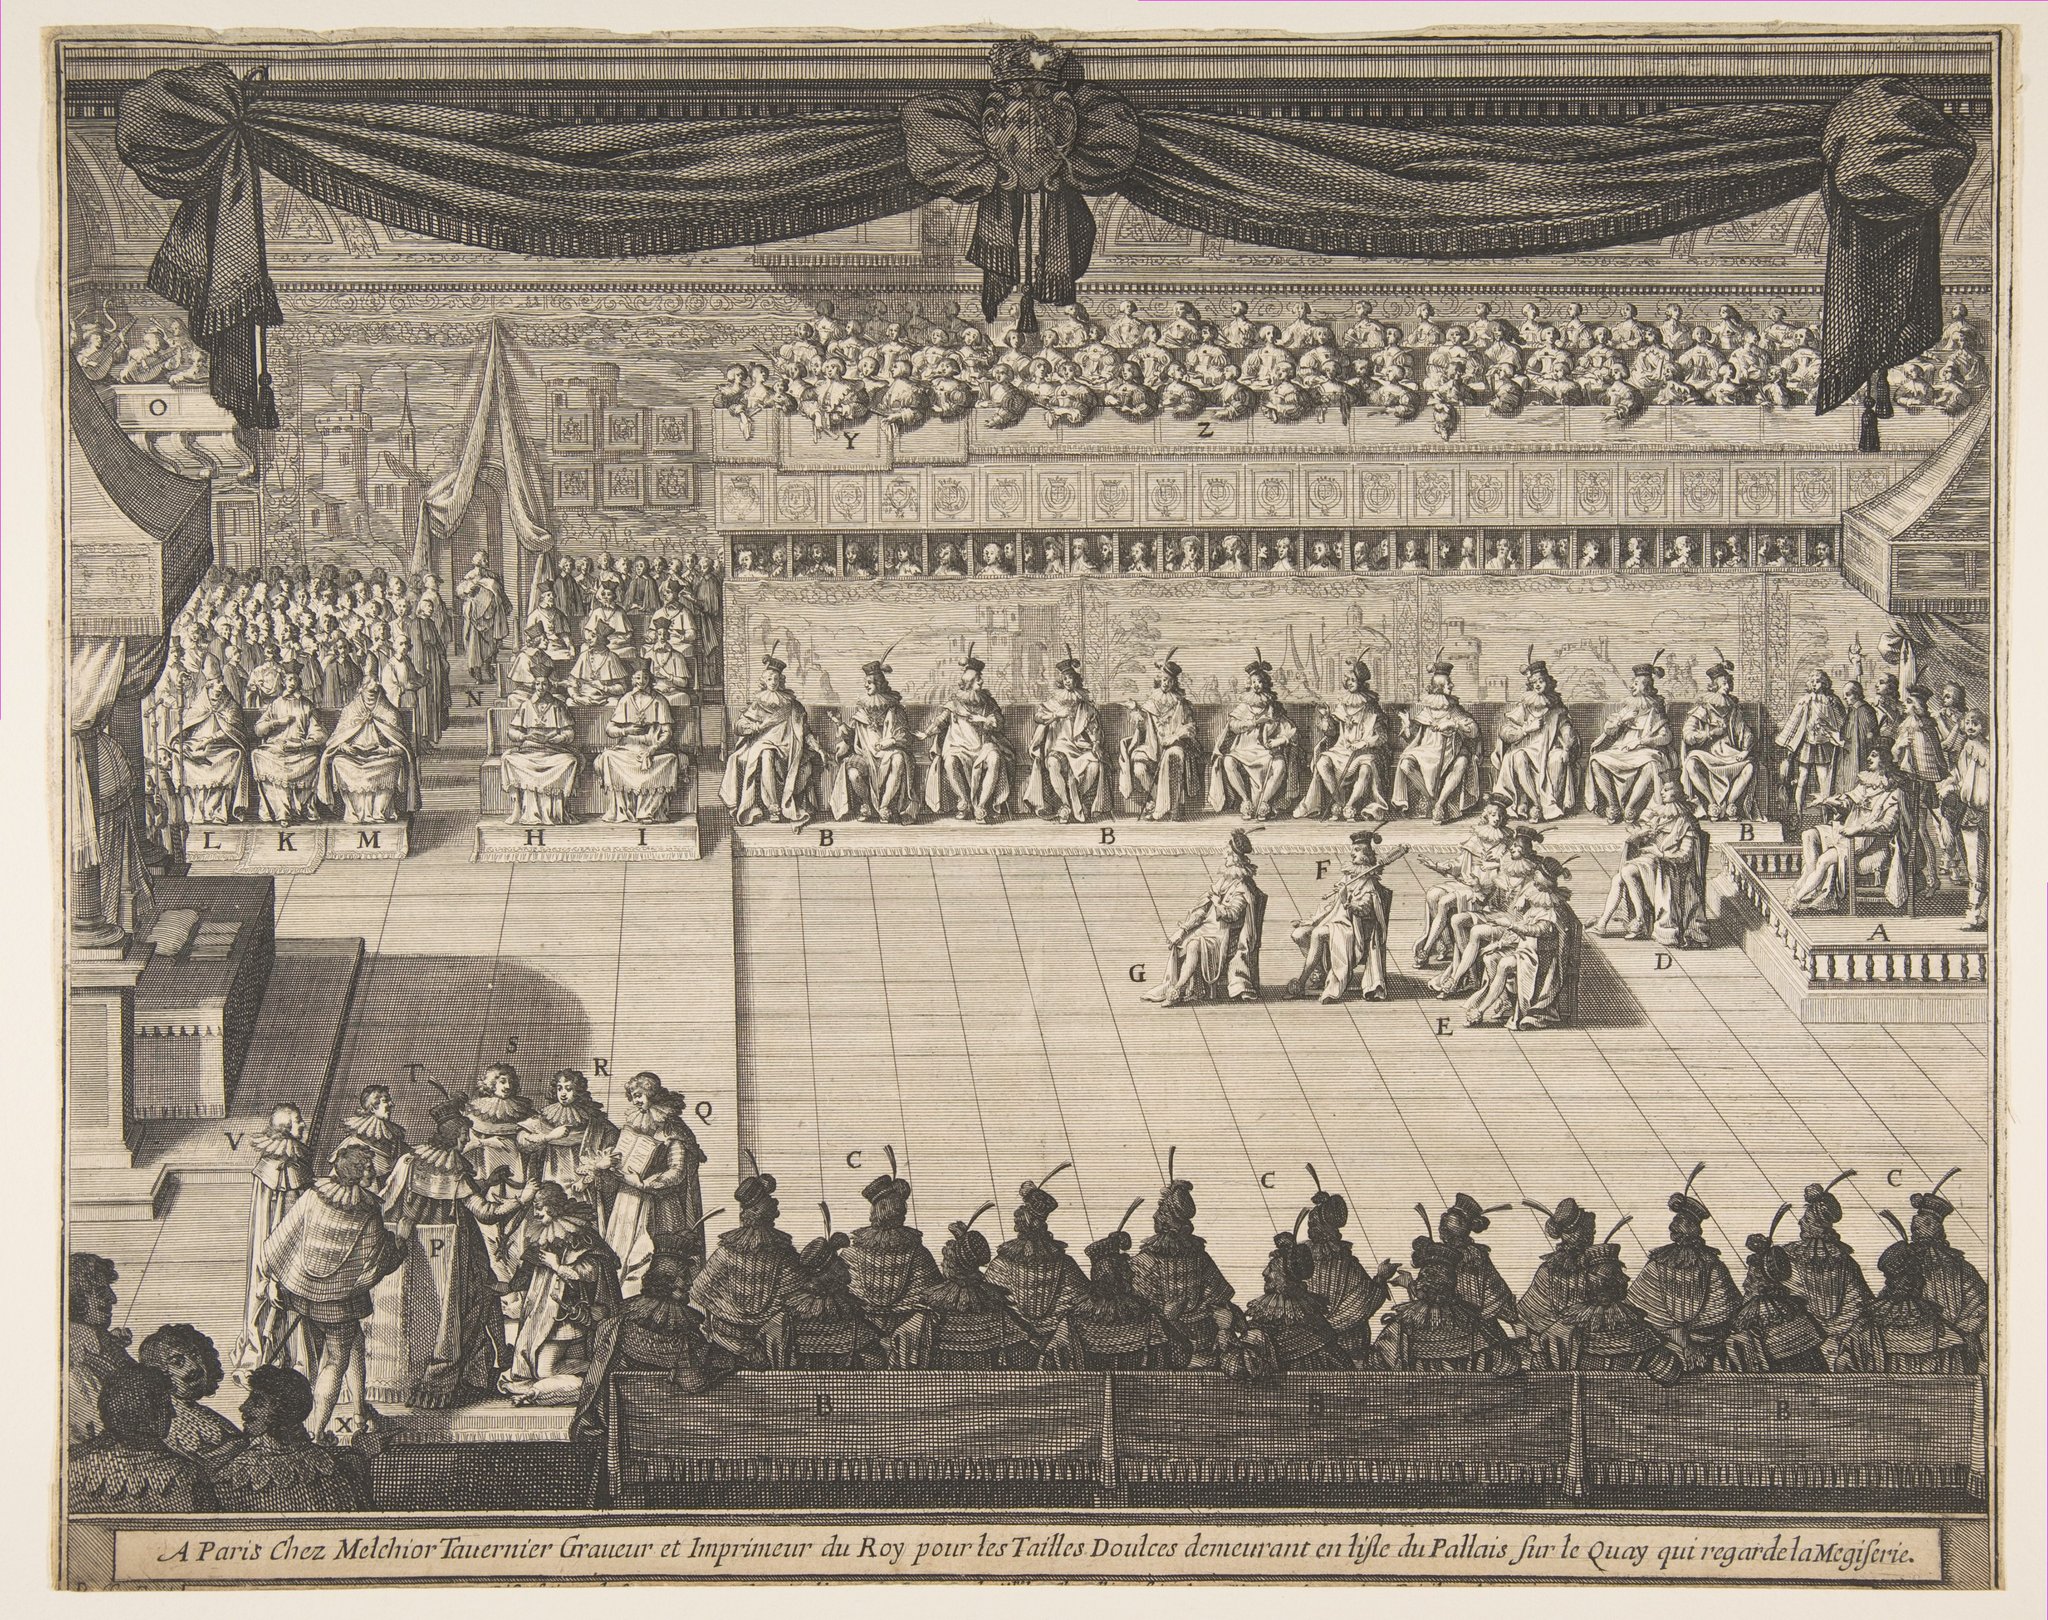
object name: print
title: Seating Arrangement of the Chevaliers of the Order of the Holy Spirit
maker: abraham bosse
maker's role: artist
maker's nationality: french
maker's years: 1602-1676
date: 1634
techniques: etching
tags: men,women,spectators,knights